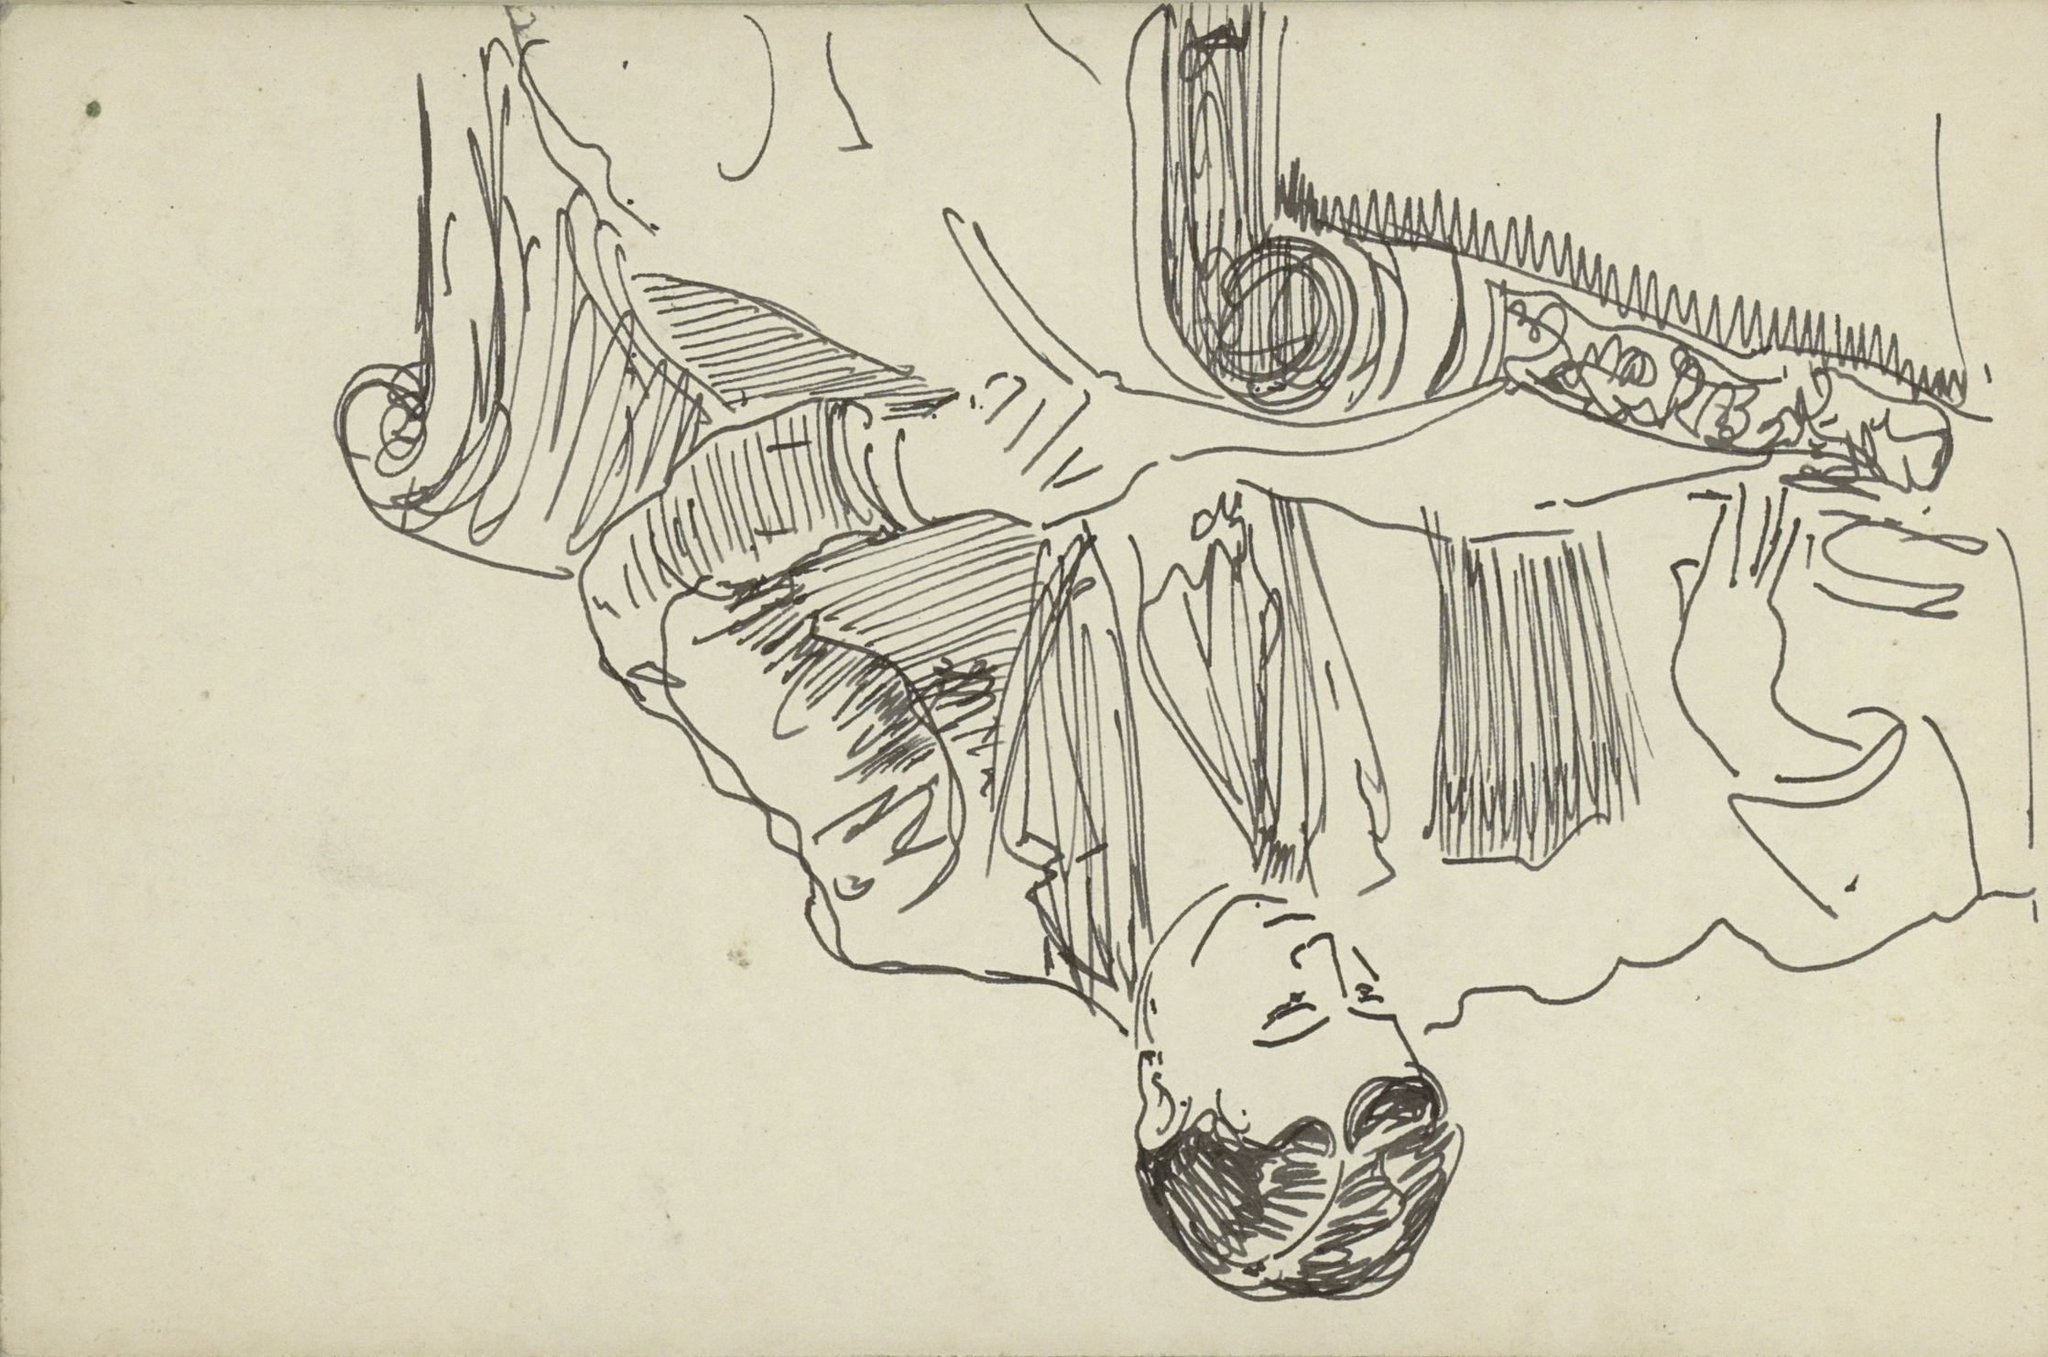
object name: sketchbook leaf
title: Man die de krant leest in een leunstoel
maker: carel adolph lion cachet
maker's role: draughtsman, print maker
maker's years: 1864-1945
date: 1930-1938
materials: ink, paper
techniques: pen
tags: sitting figure, reading, newspaper, news-sheet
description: Blad 9 verso uit een schetsboek met 9 bladen.